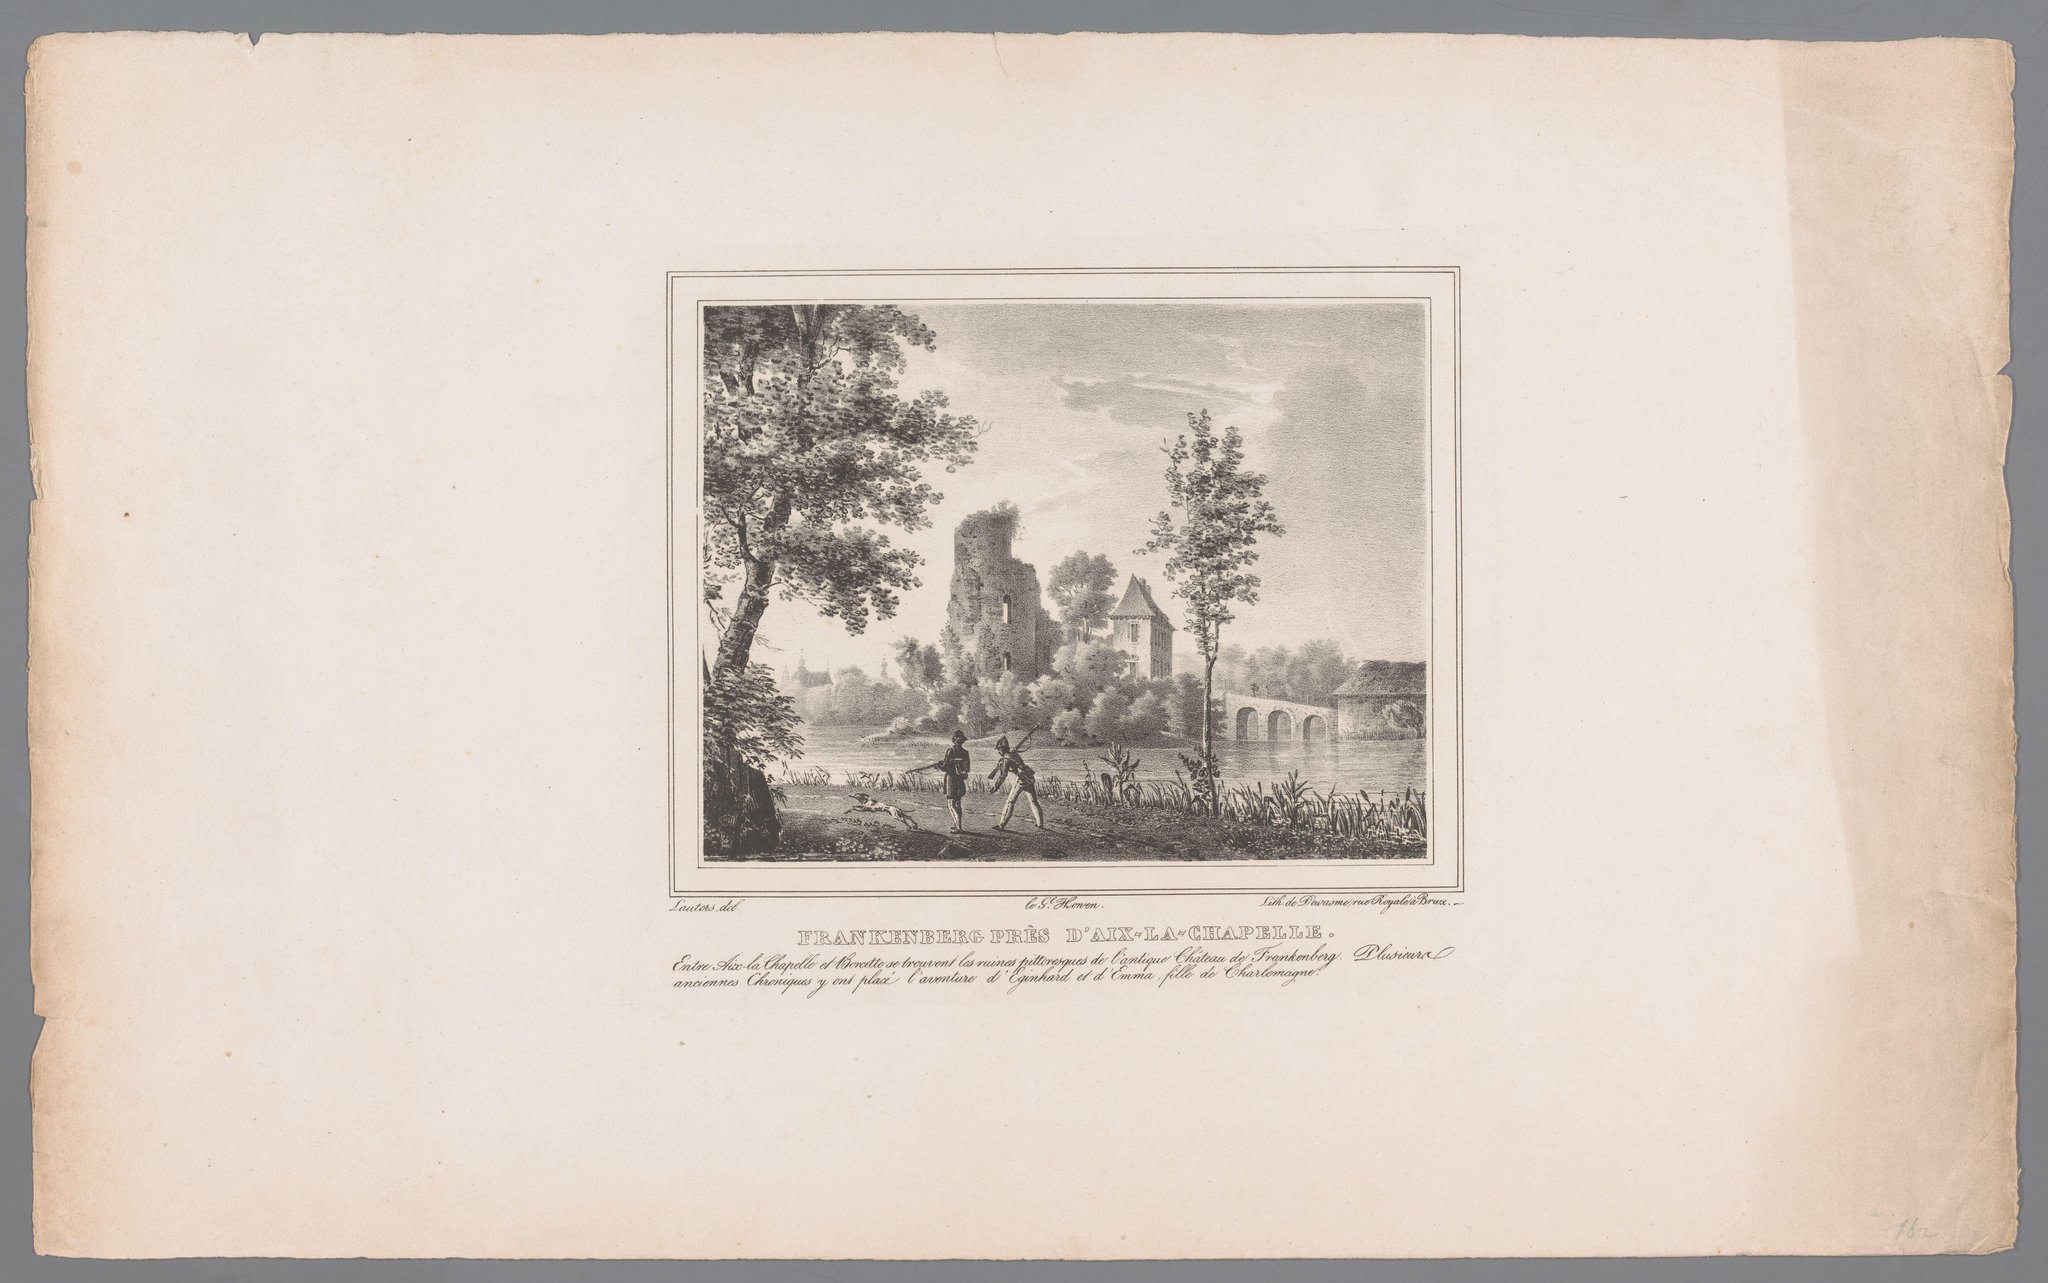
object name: print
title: Gezicht op Burg Frankenberg bij Aken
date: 1816-1848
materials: paper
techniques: lithograph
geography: brussels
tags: landscape with ruins, ruin of a dwelling, house, castle, etc.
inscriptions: collector's mark: Lugt 2228